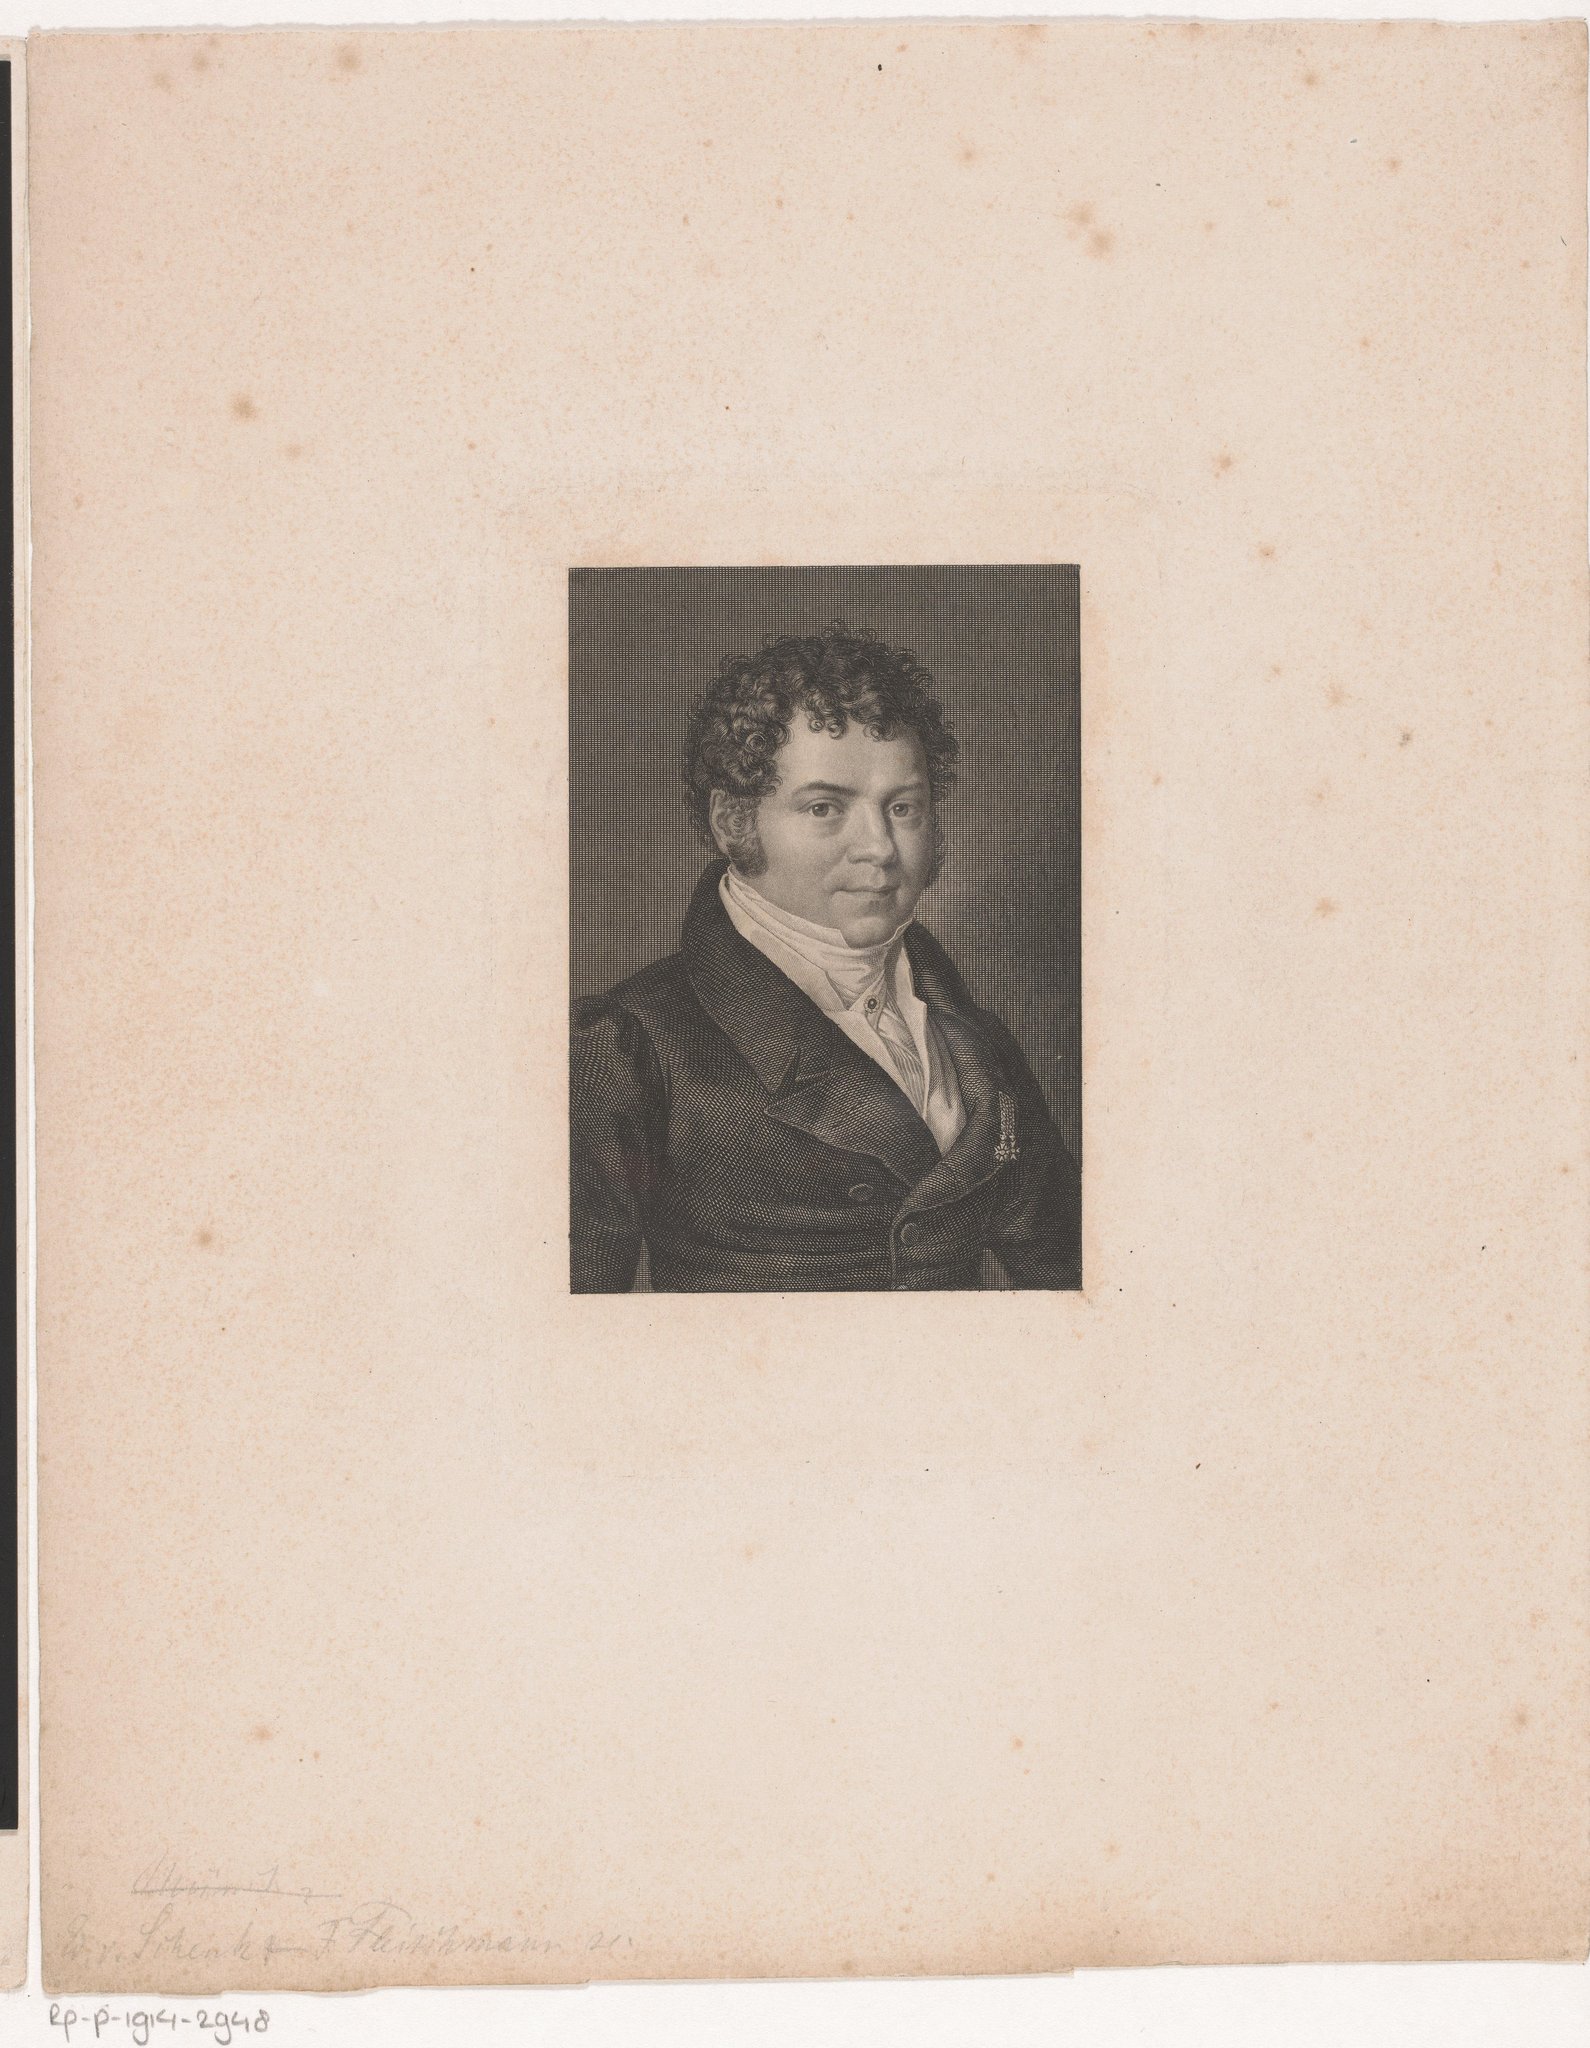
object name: print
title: Portret van Eduard von Schenk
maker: friedrich fleischmann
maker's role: print maker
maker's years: 1791-1834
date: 1801-1834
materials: paper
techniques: engraving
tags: historical persons, portrait of a writer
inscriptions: collector's mark: Lugt 2228